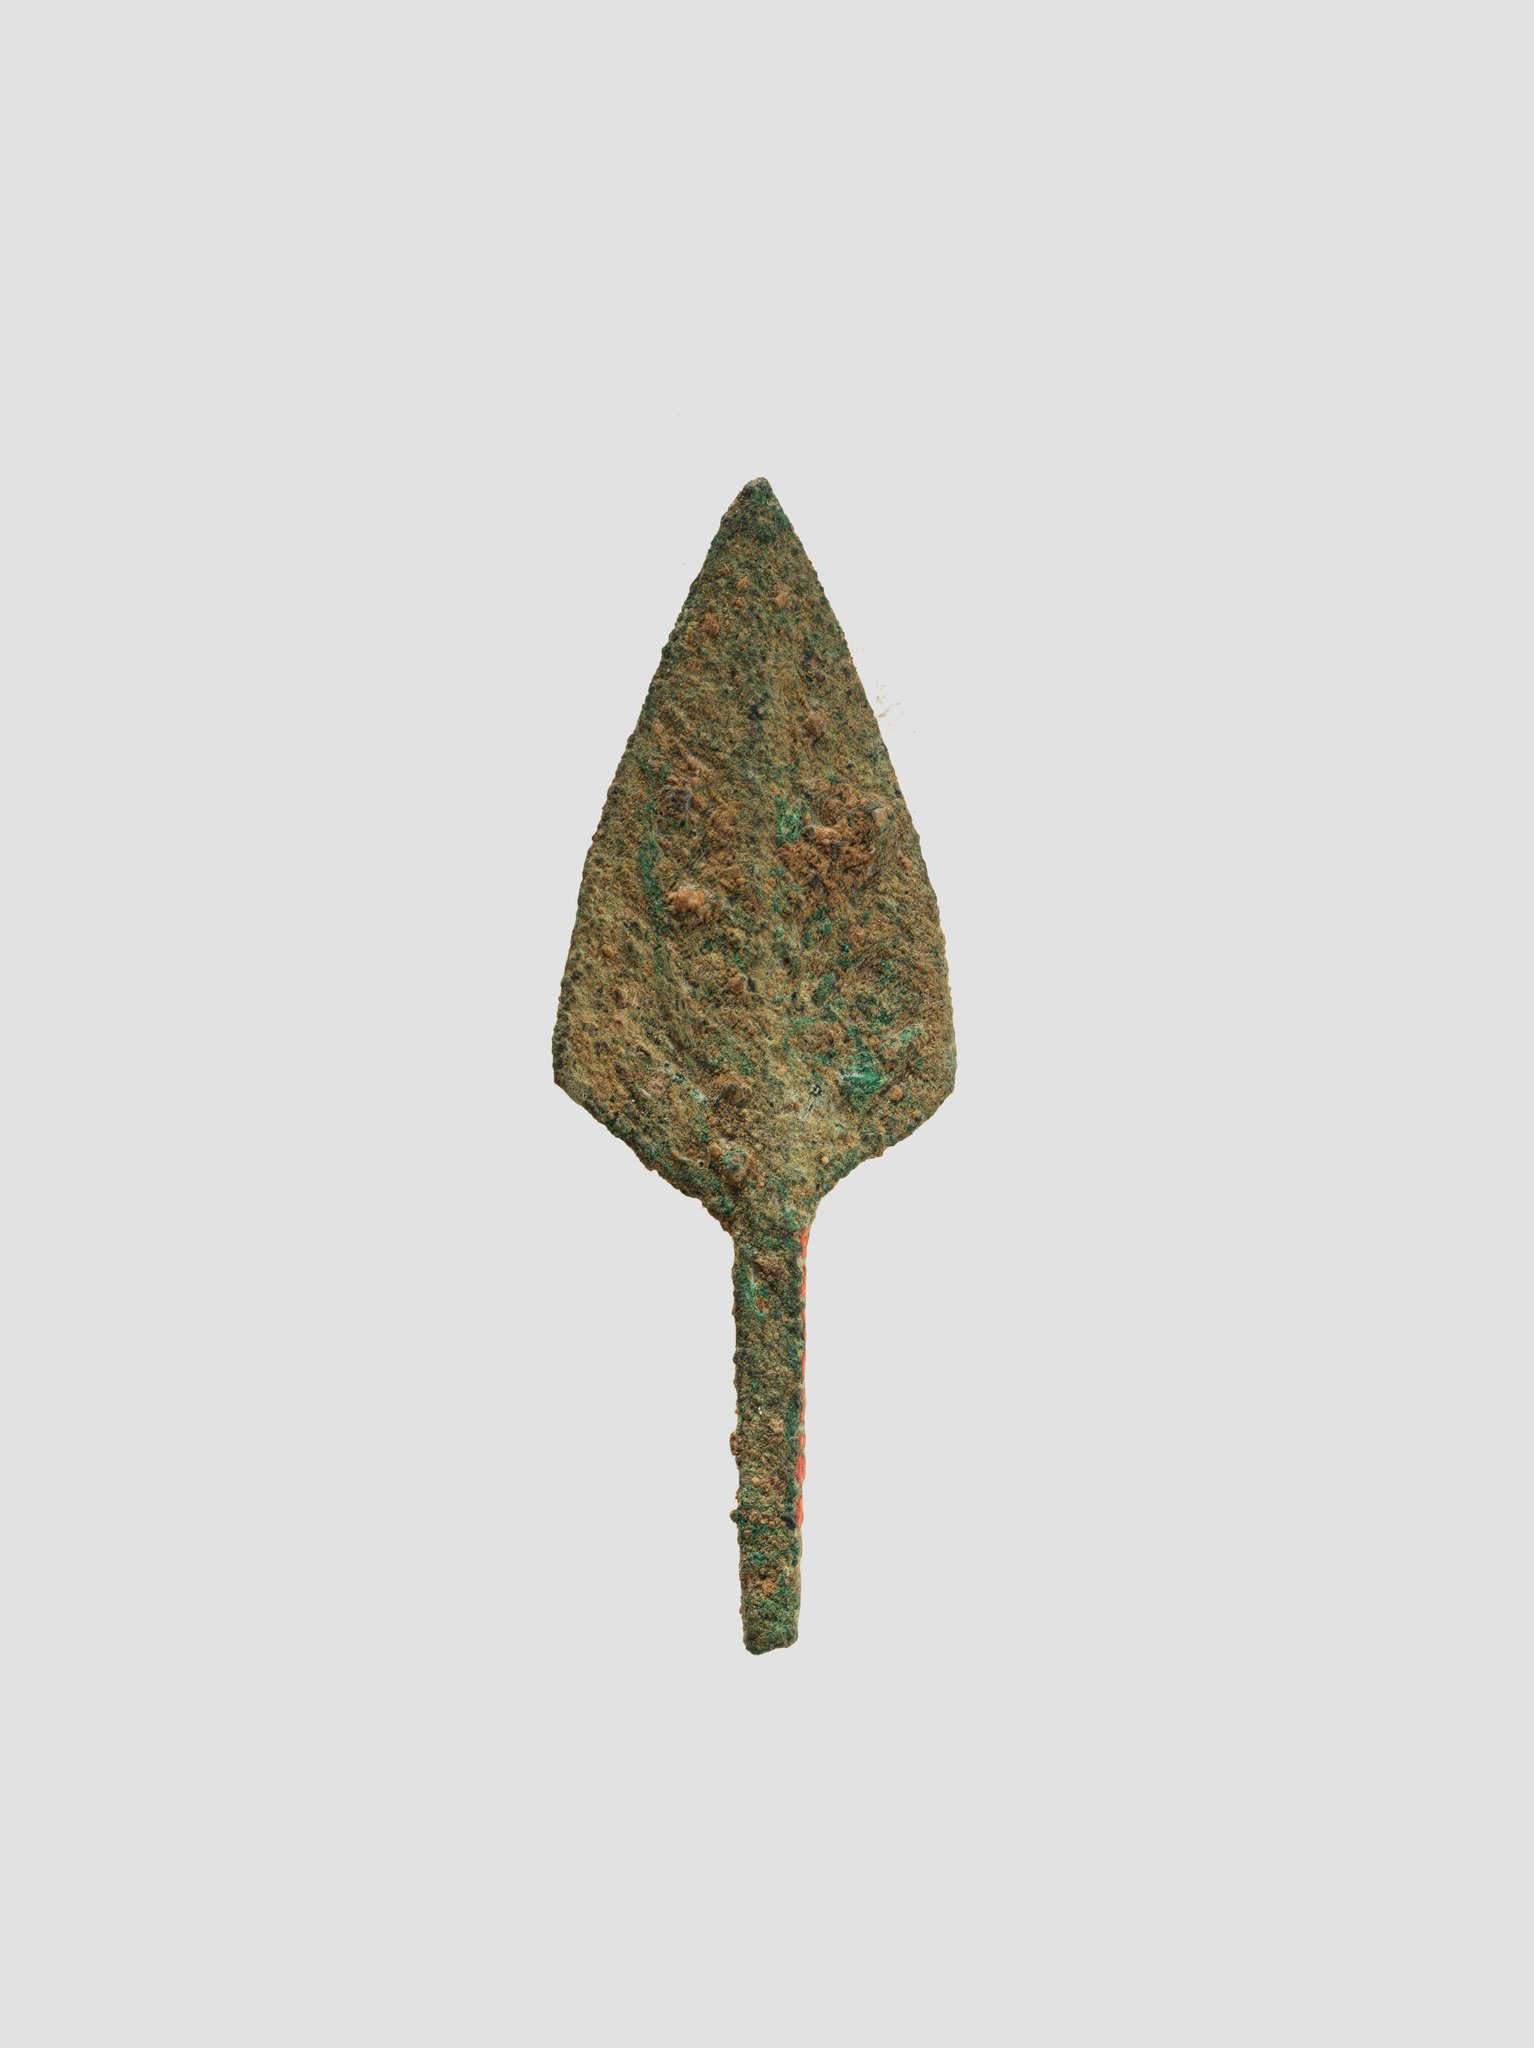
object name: arrowhead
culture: sasanian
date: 201-700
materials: bronze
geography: iran